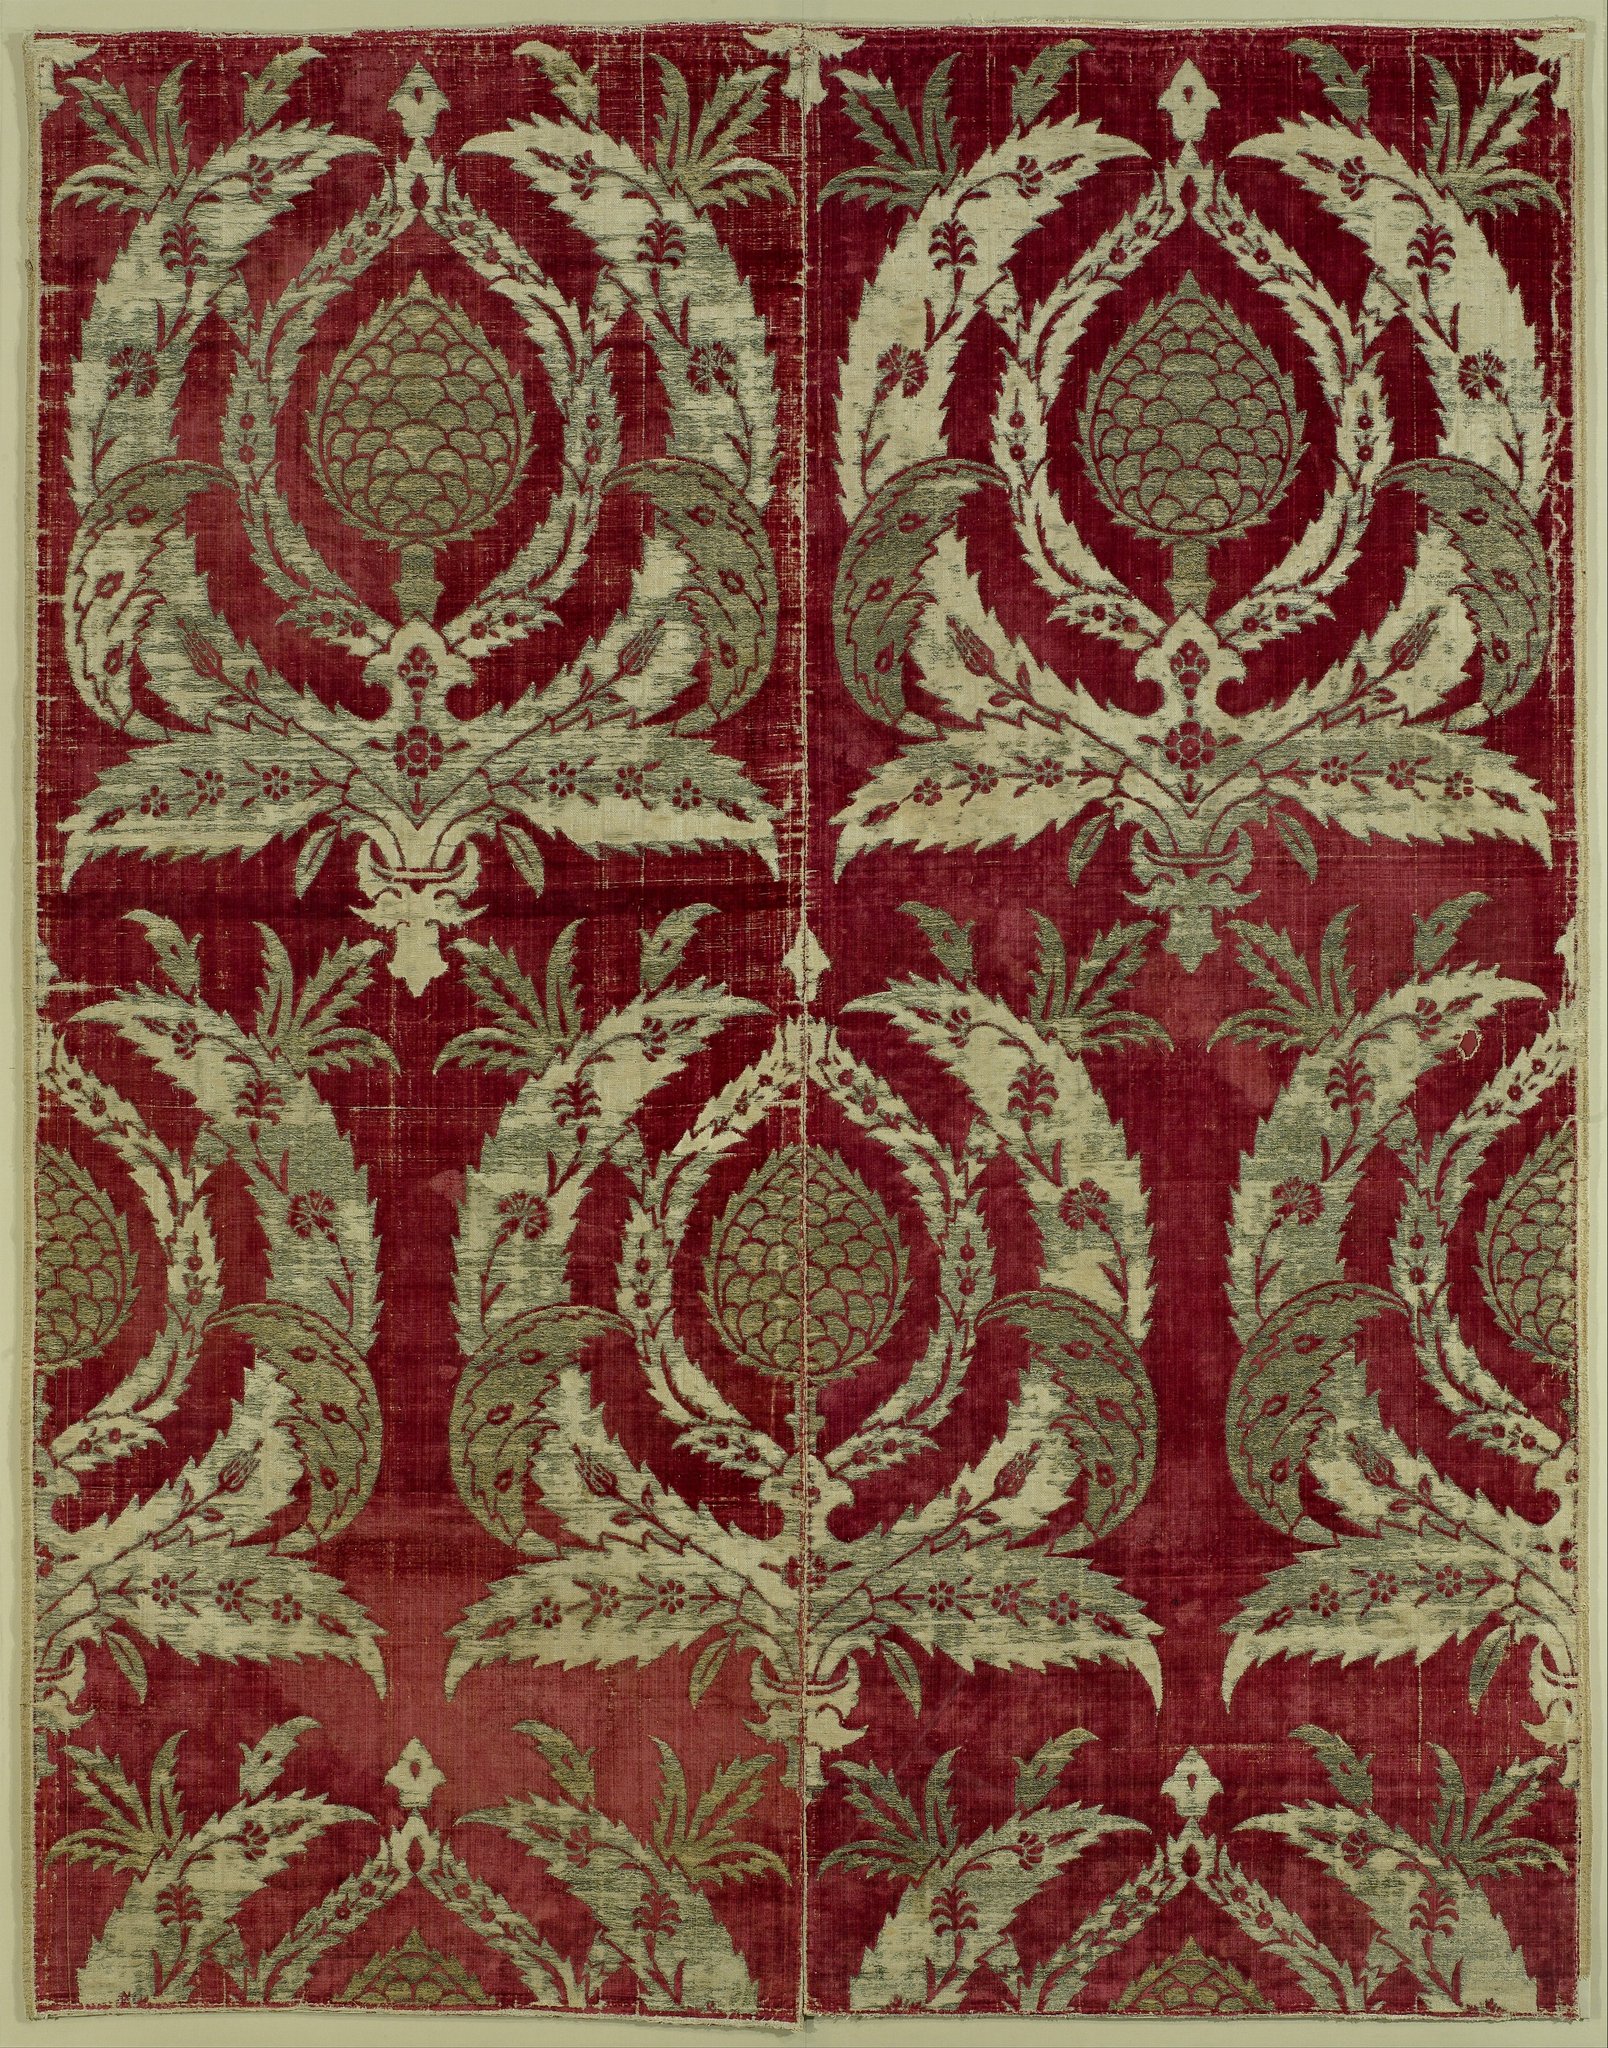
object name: textile fragment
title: Rectangular Textile Fragment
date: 1551-1600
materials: metal thread, silk, velvet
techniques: brocade, cutting, voiding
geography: turkey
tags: leaves